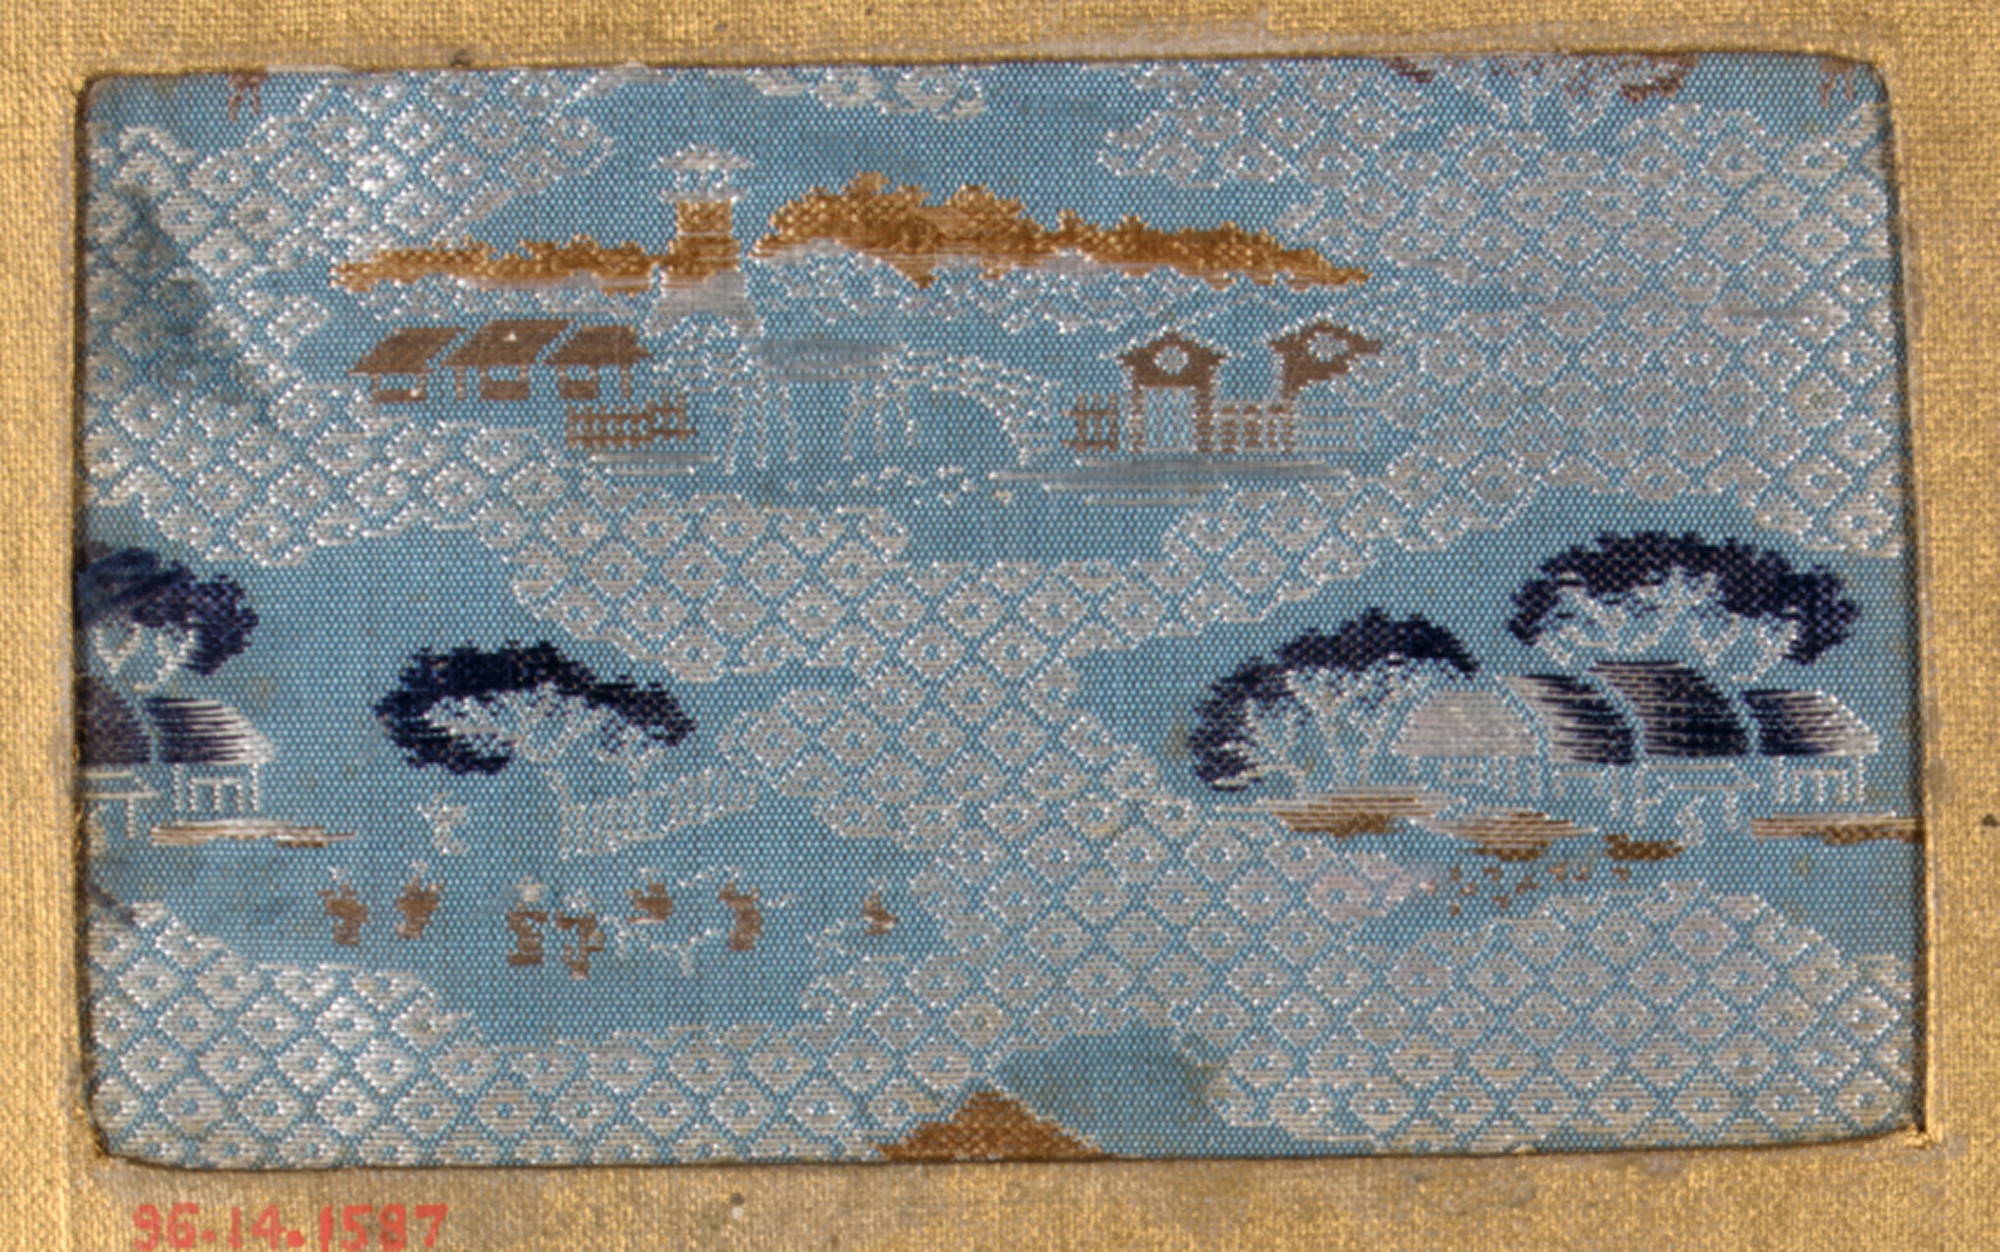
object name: piece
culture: japanese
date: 1701-1900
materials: silk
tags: houses